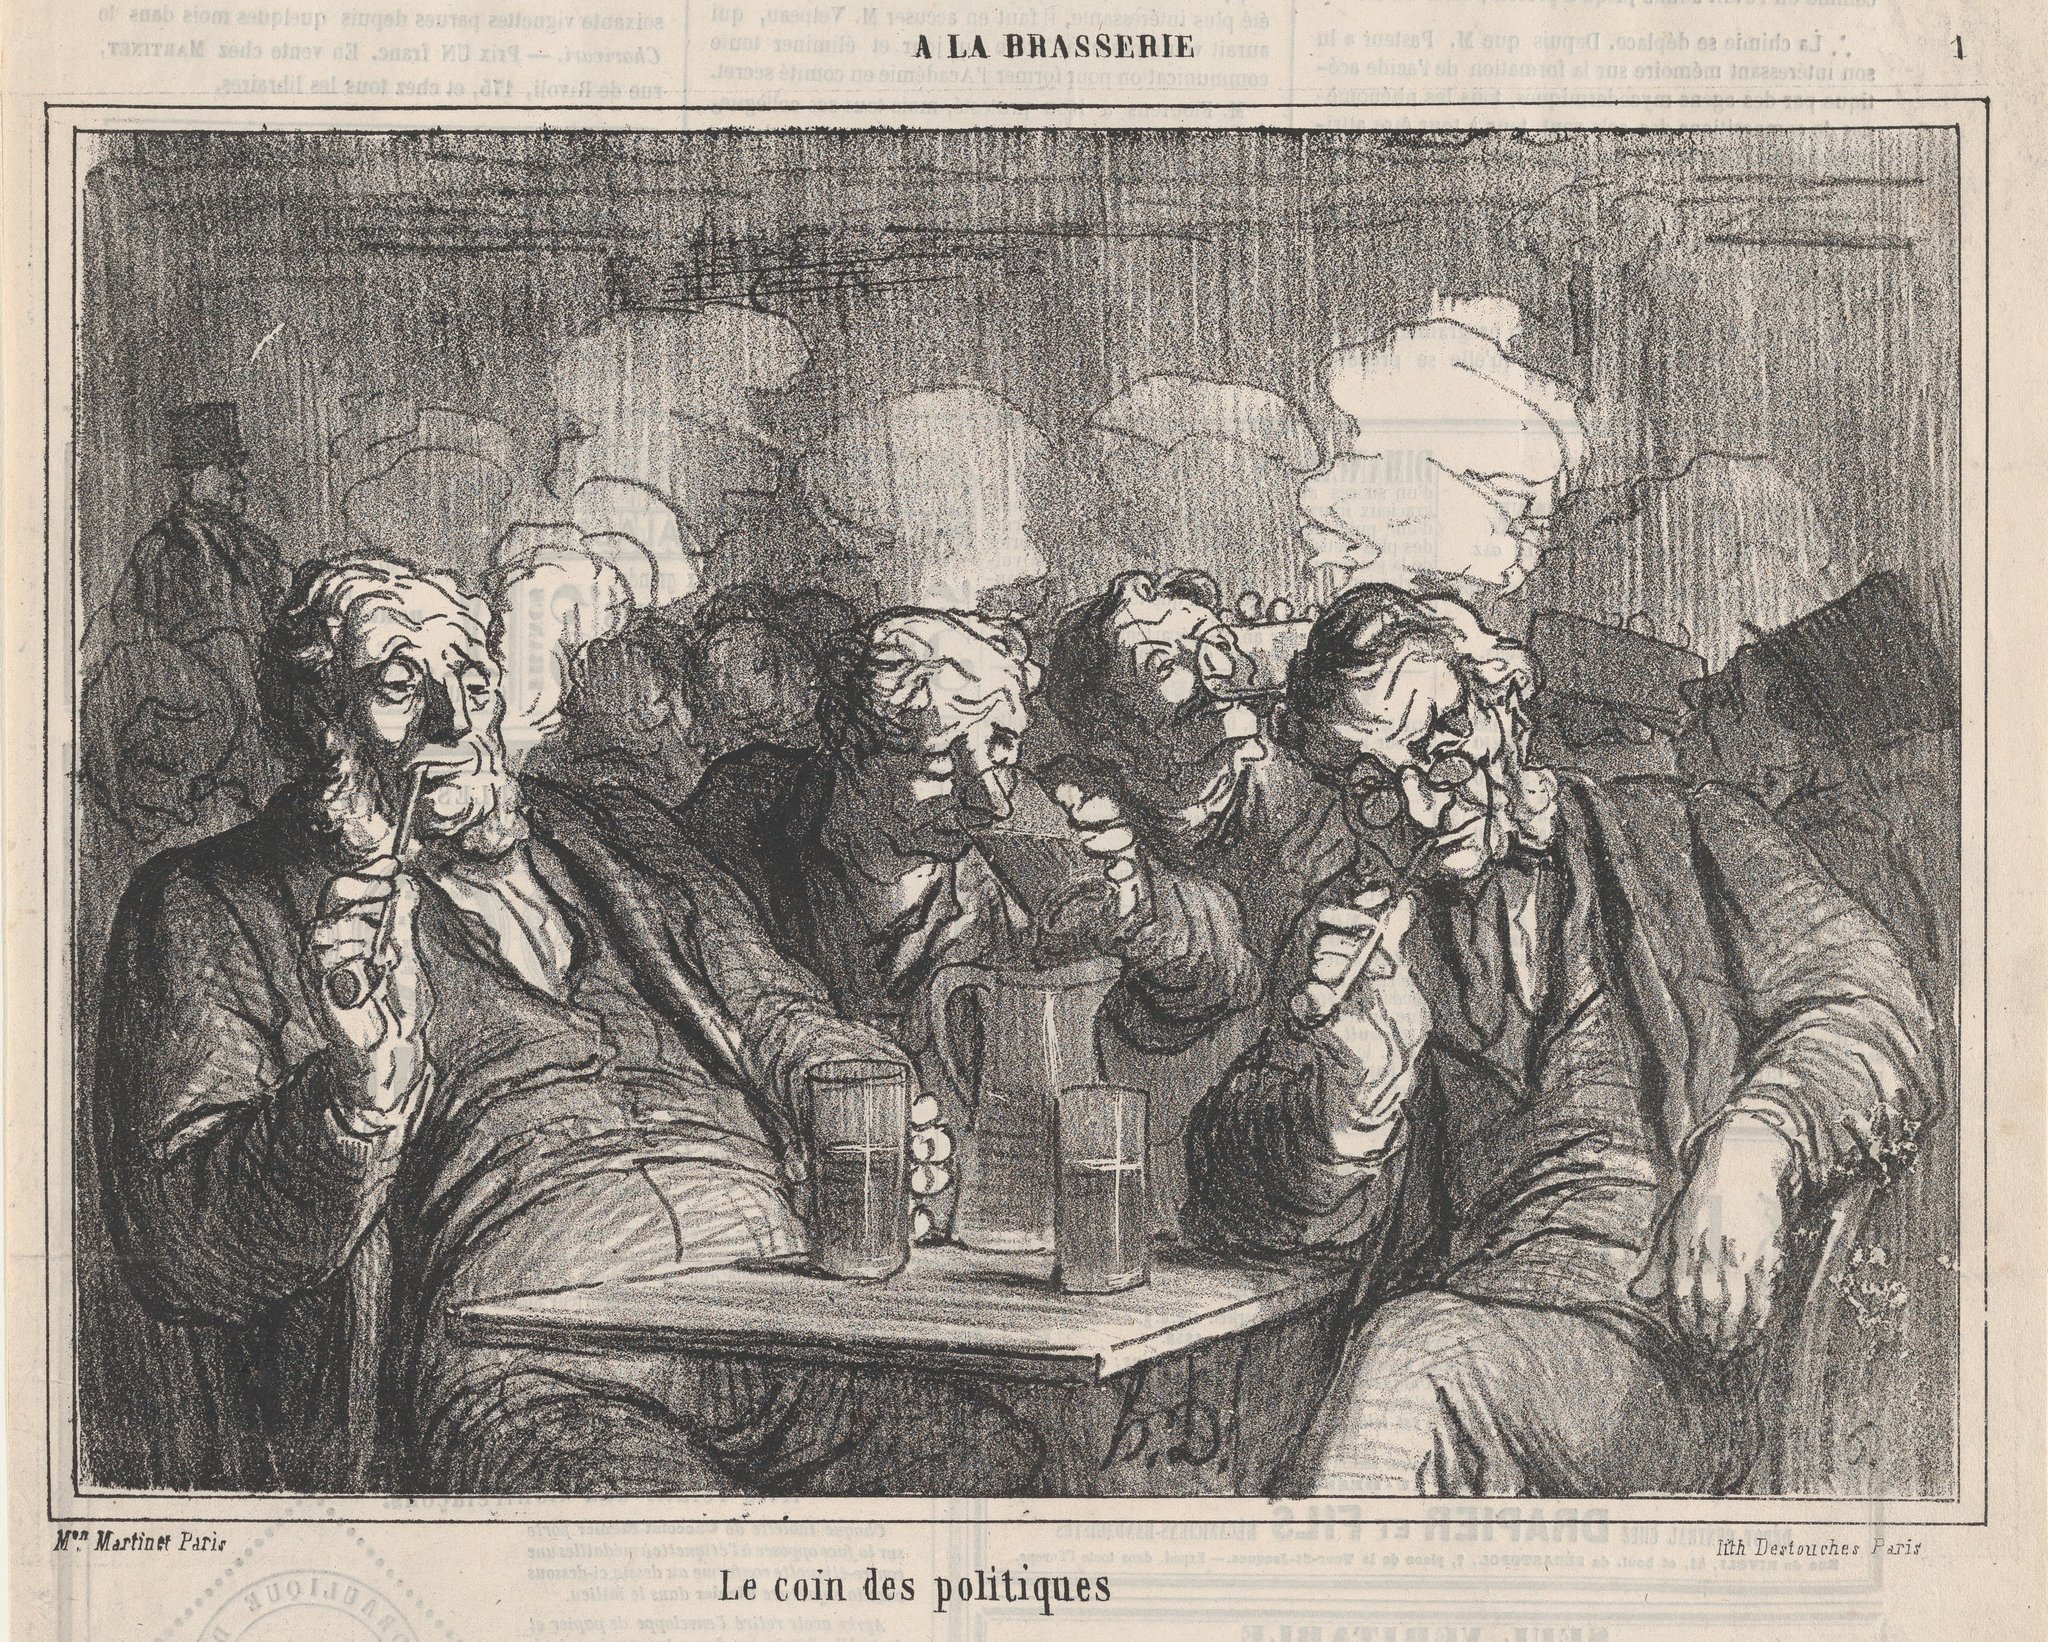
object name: print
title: The politician's corner, from 'In the pub,' published in Le Charivari, January 5, 1864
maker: honoré daumier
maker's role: artist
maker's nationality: french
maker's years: 1808-1879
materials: paper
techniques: lithograph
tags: men,smoking,drinking